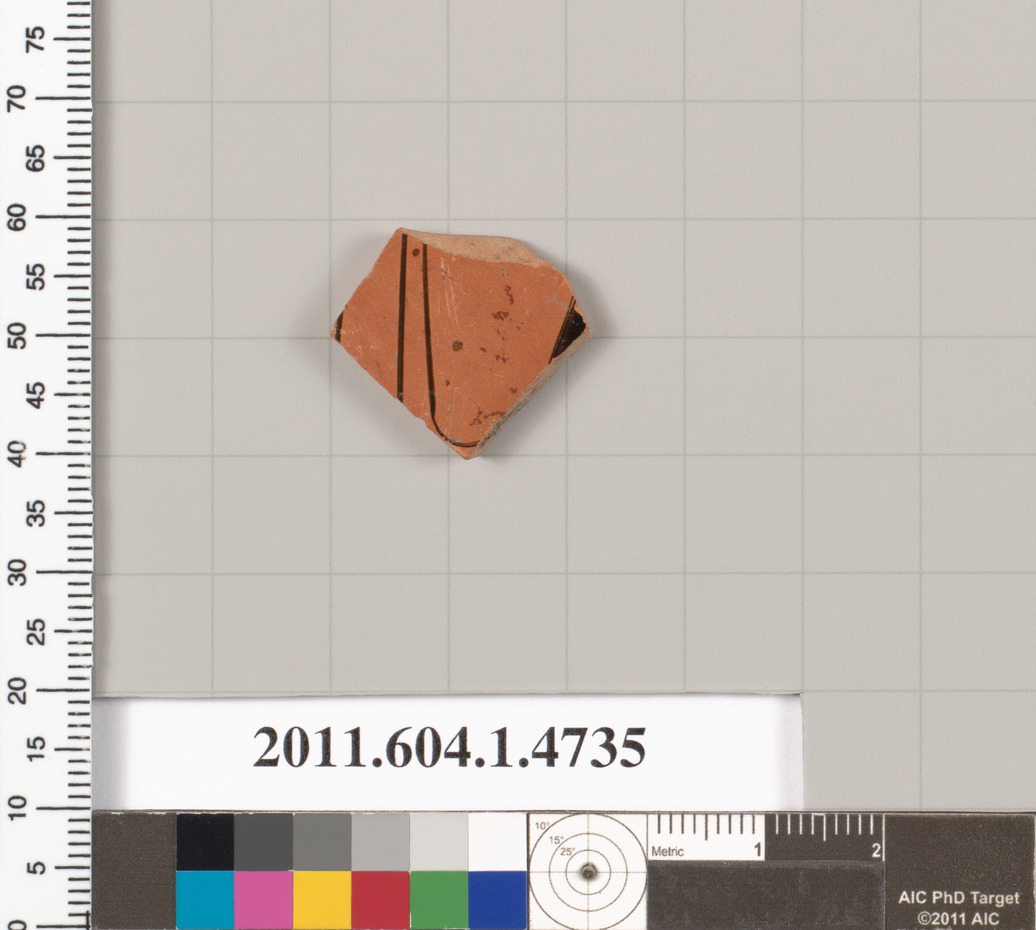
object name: kylix fragment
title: Terracotta fragment of a kylix (drinking cup)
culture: greek, attic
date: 475-451 BCE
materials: terracotta